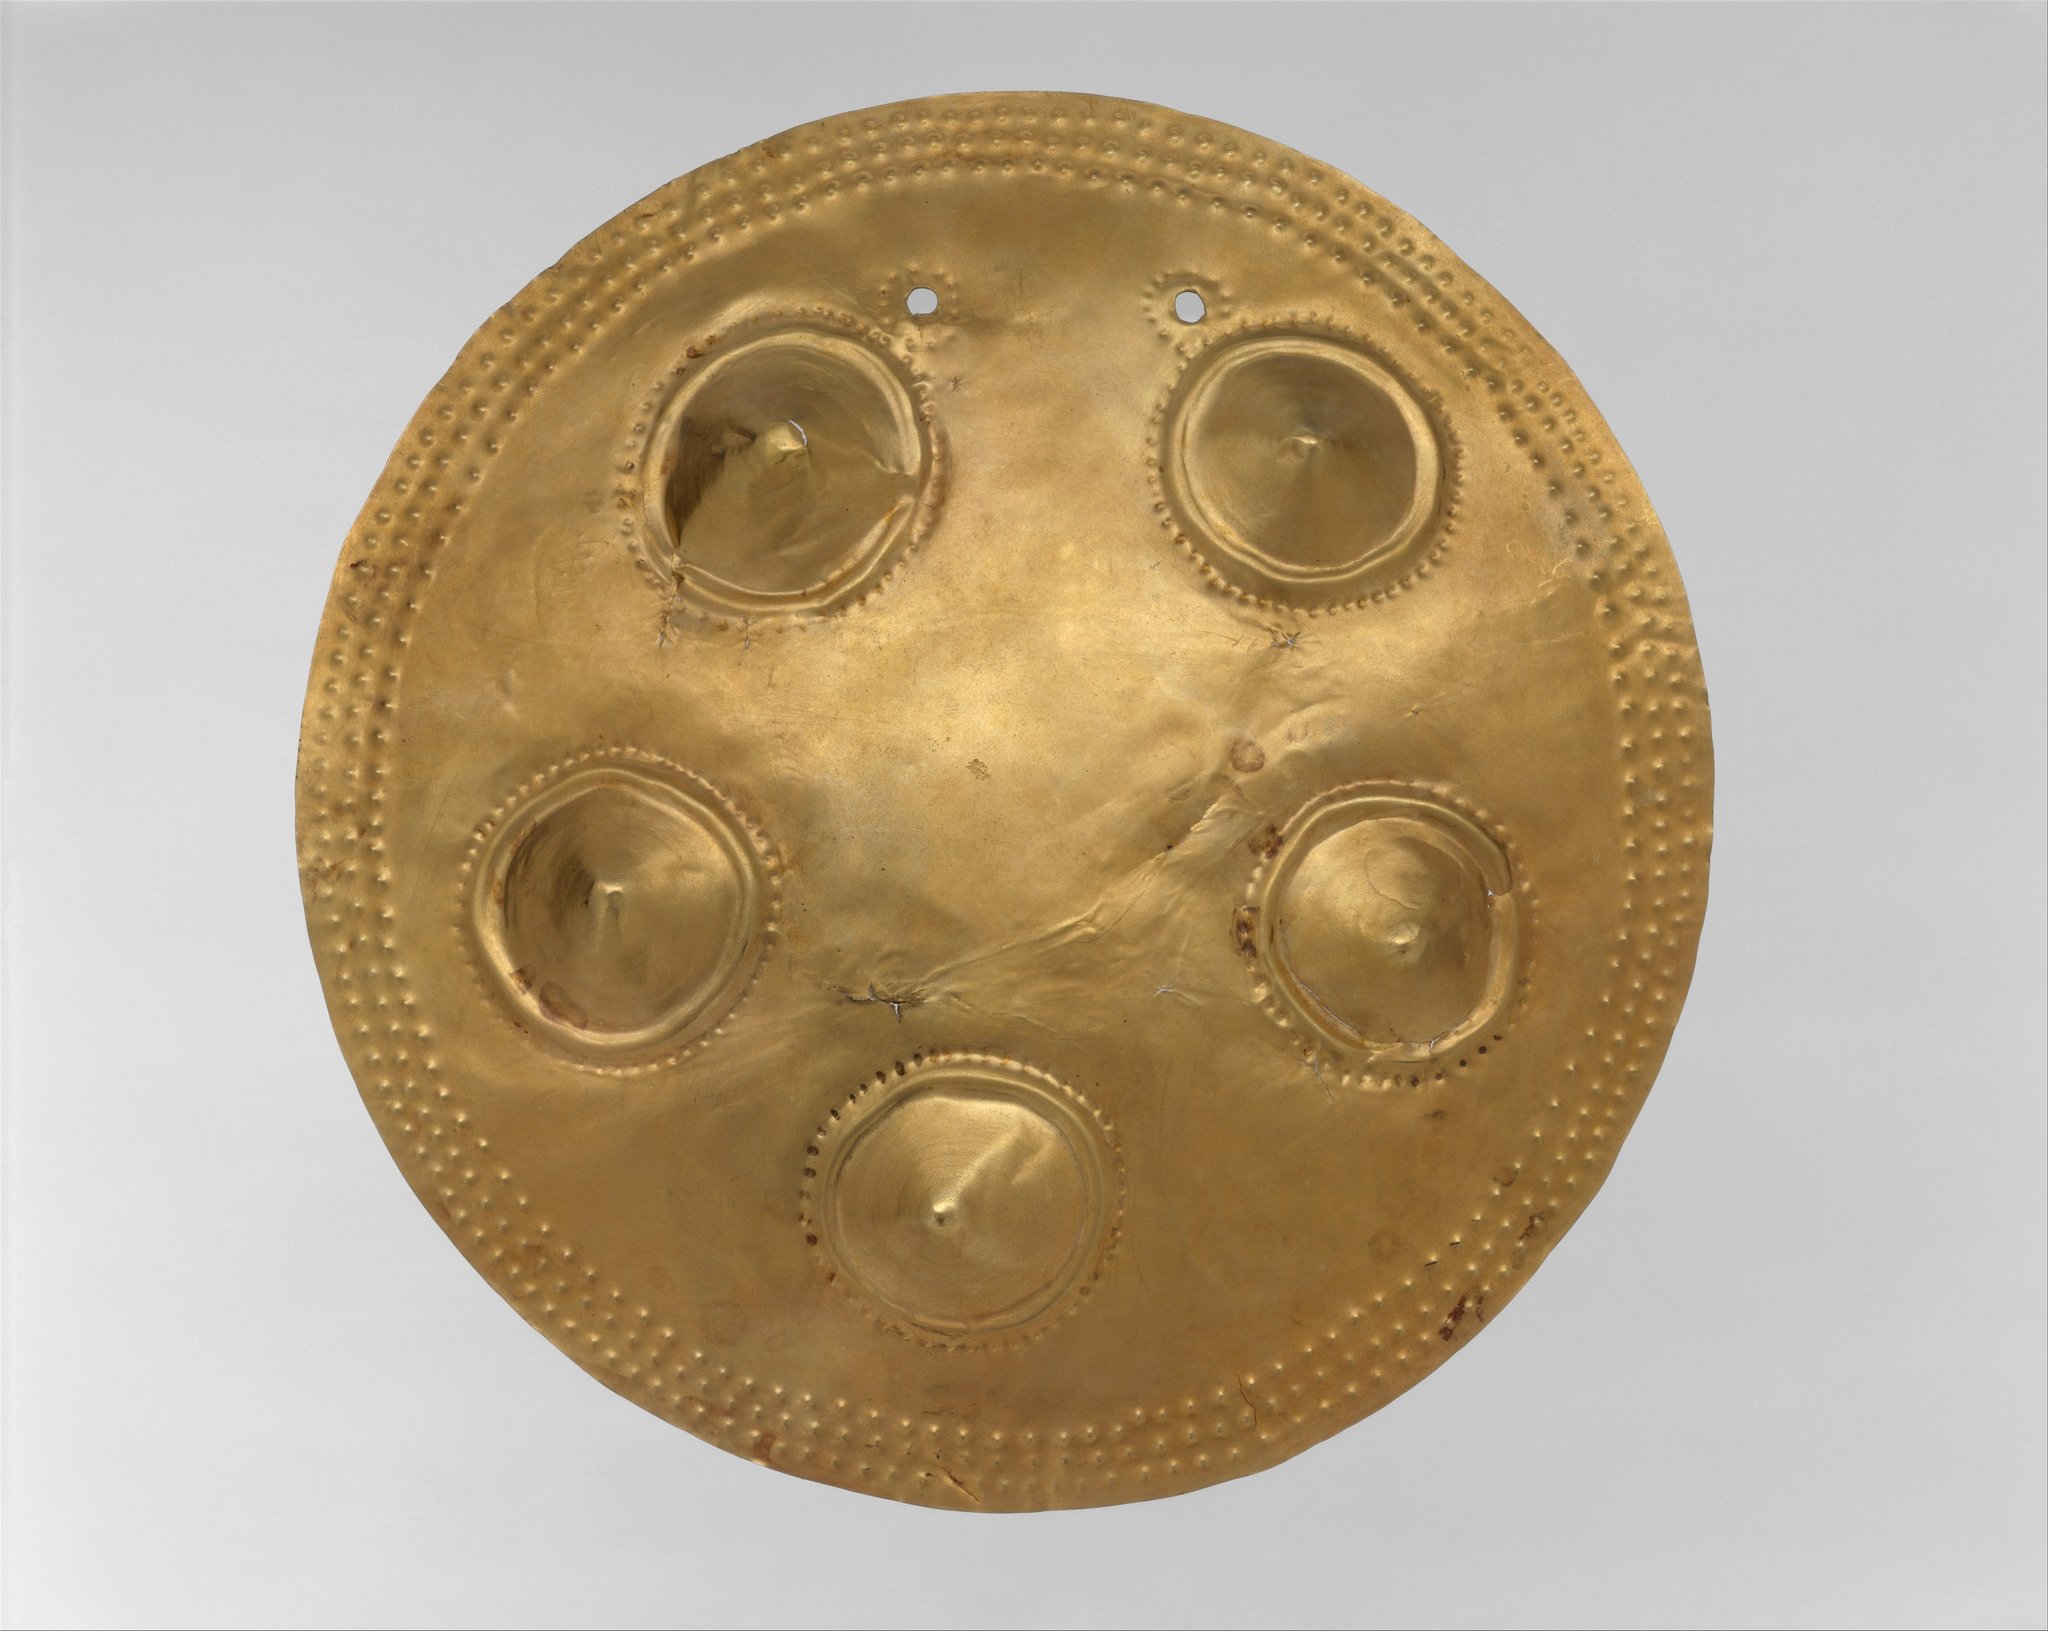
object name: pectoral disk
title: Pectoral Disk (Patena)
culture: veraguas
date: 1001-1600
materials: gold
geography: panama